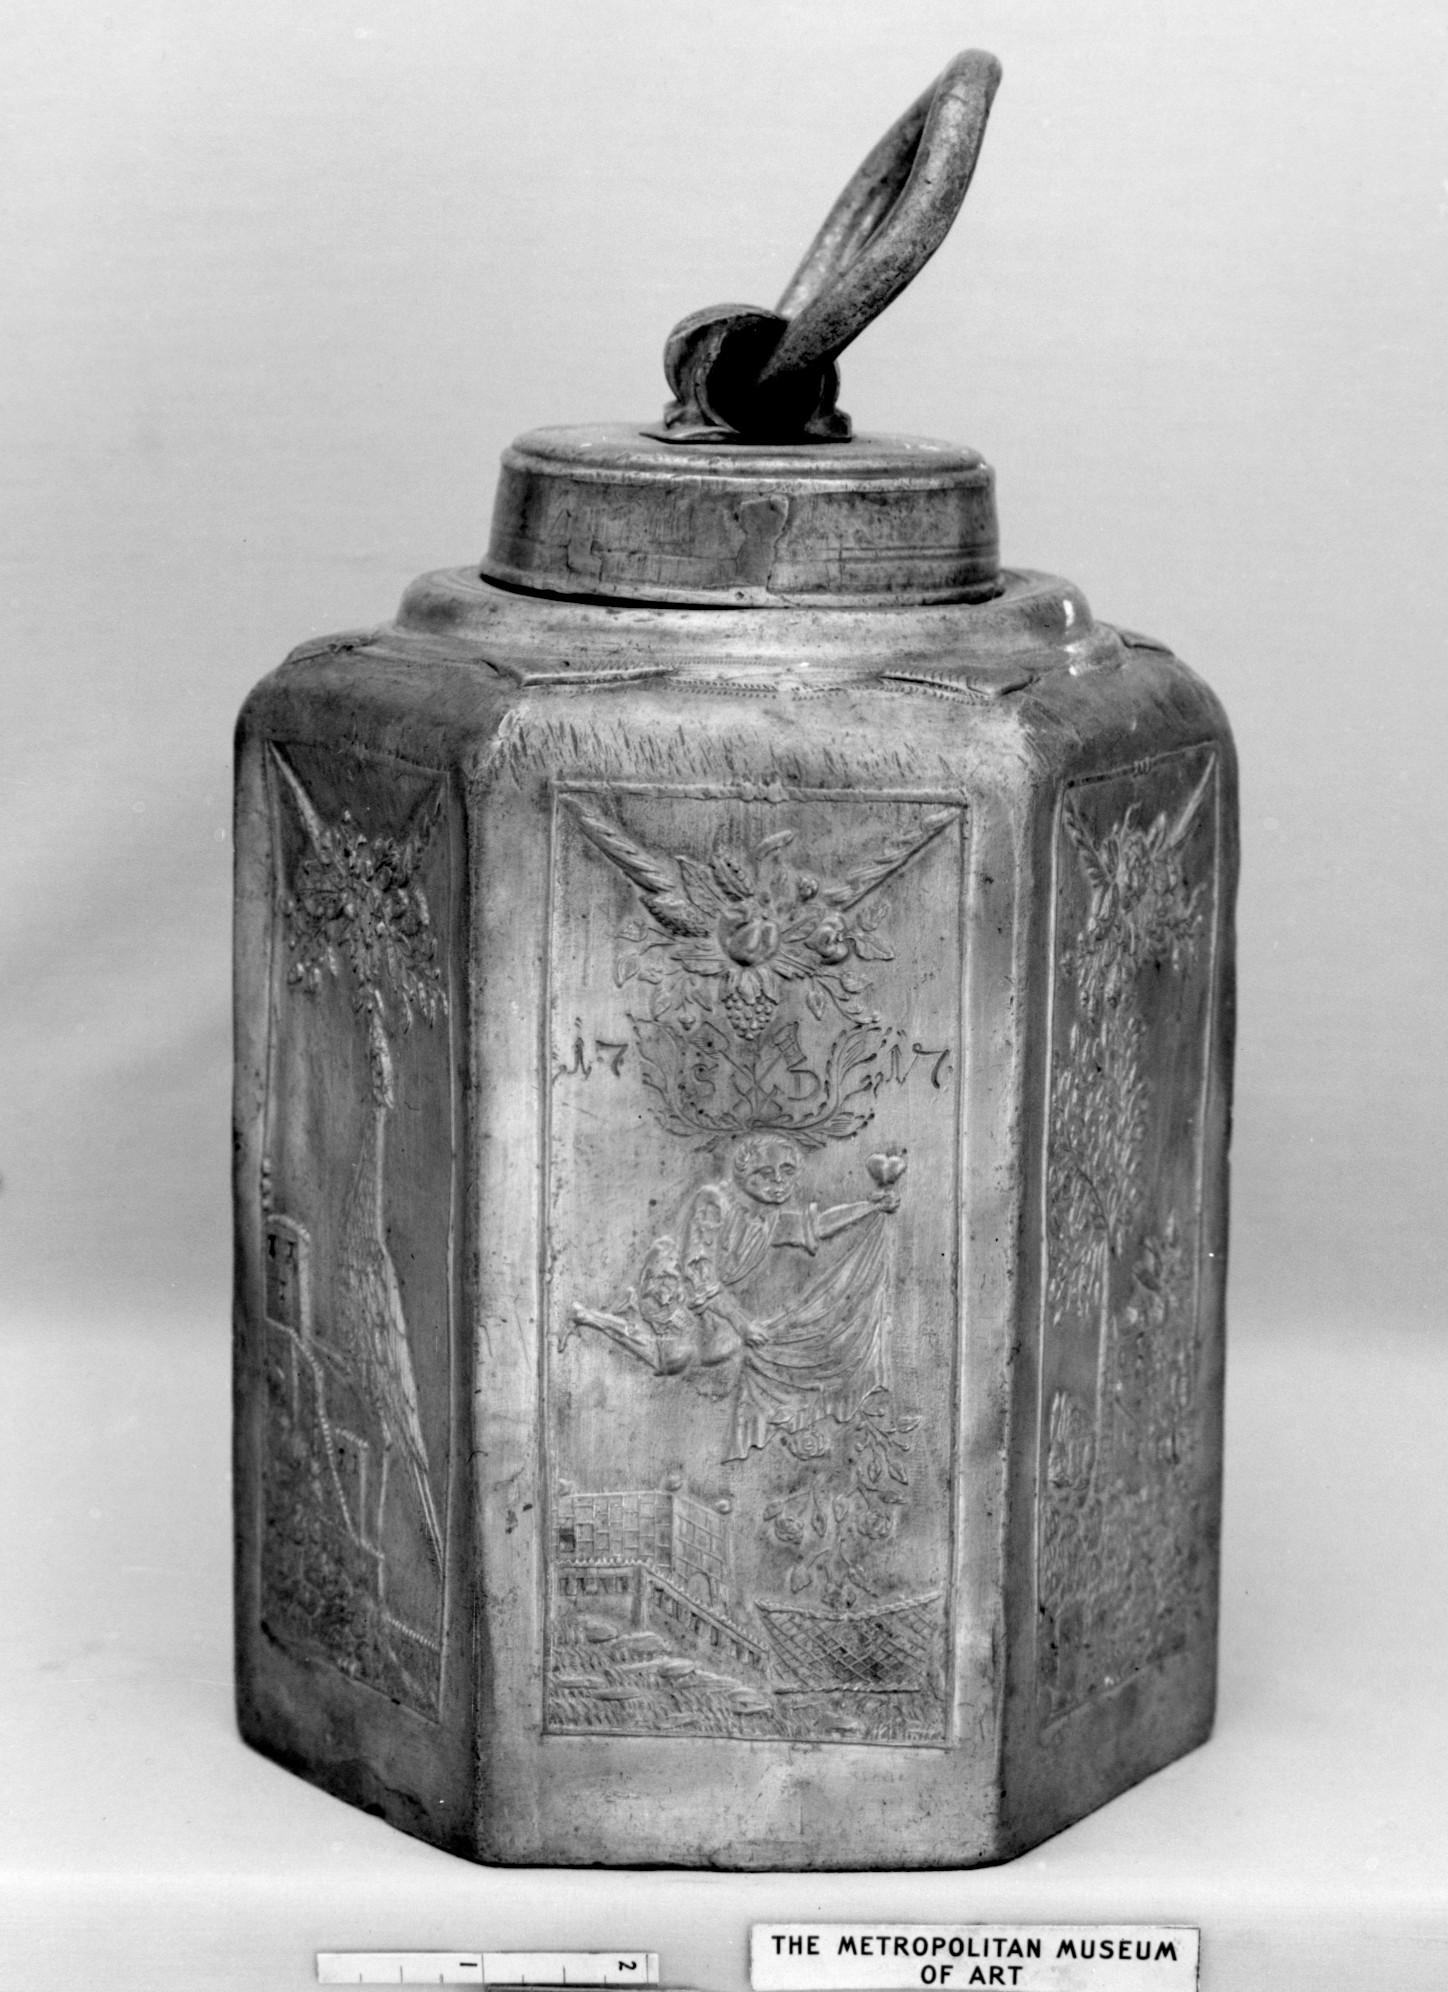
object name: food bottle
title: Food bottle (?)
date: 1701-1733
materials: pewter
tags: human figures,birds,flowers